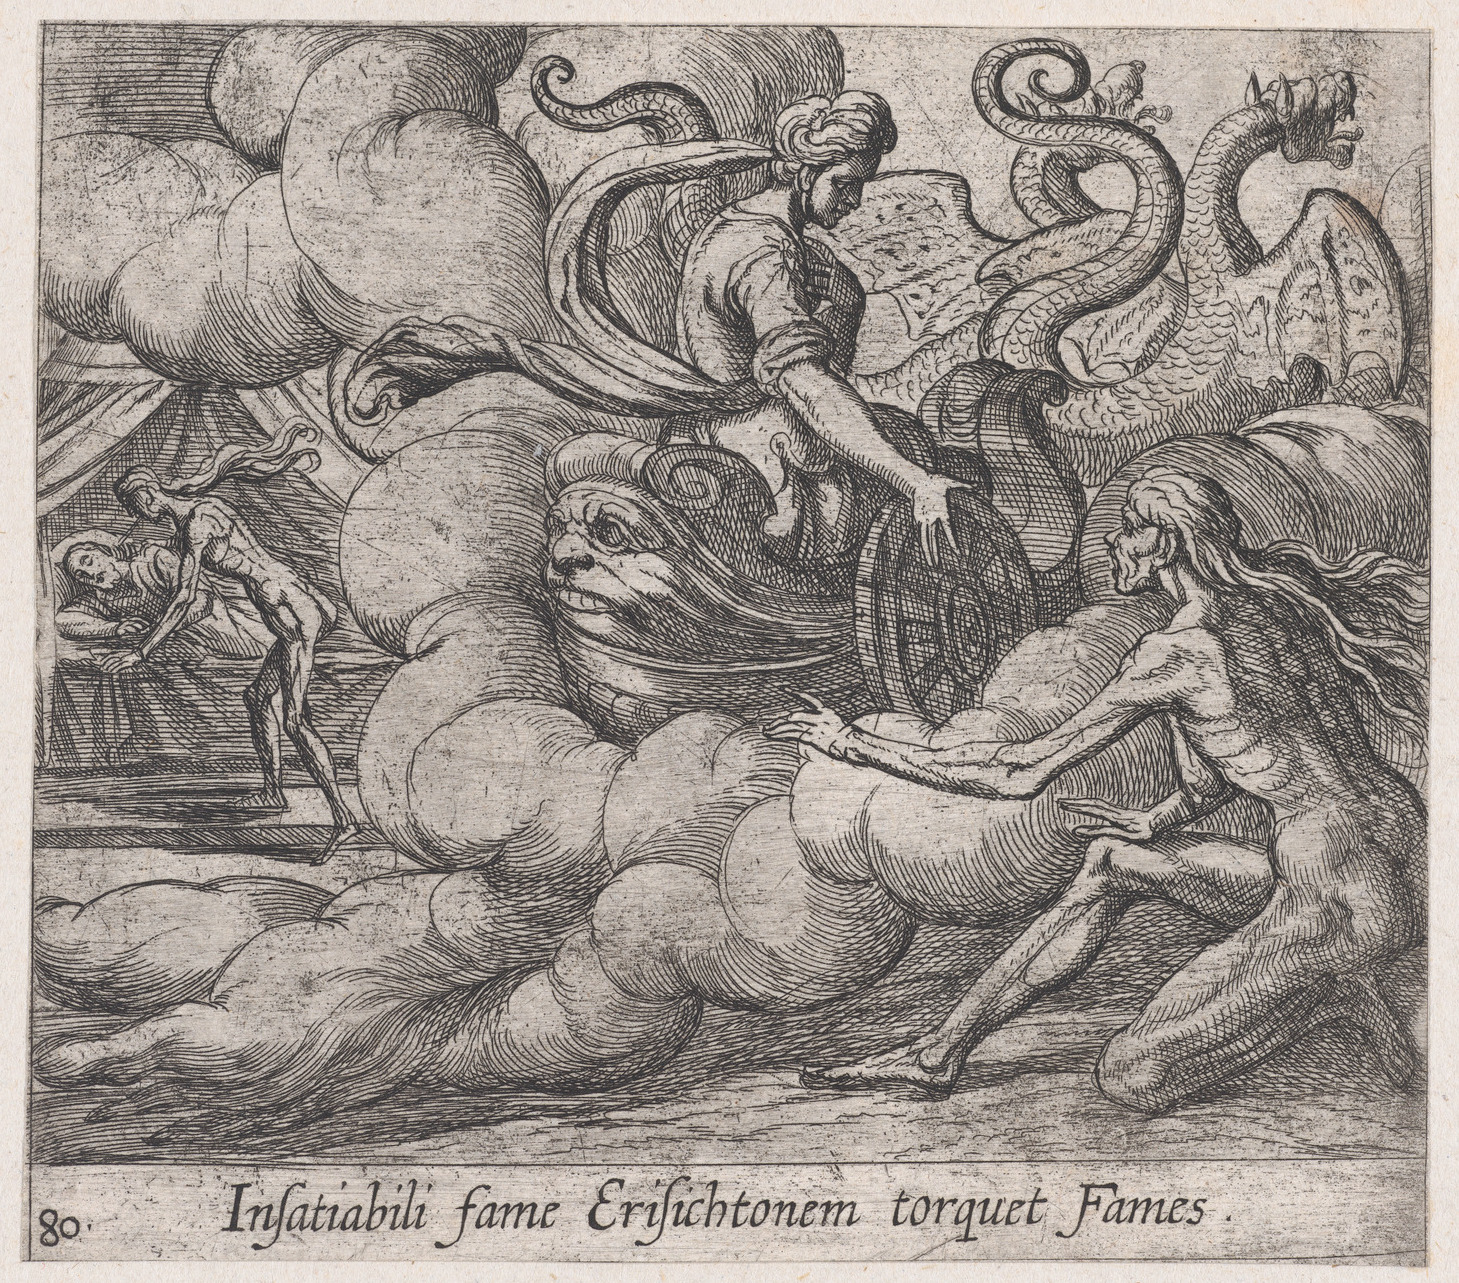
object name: print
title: Plate 80: Ceres' Nymph Telling Famine to Strike Erysichthon (Insatiabili fame Erisichtonem torquet Fames), from Ovid's 'Metamorphoses'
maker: antonio tempesta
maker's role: artist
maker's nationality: italian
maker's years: 1555-1630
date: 1606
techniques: etching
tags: dragons,nymphs,chariots